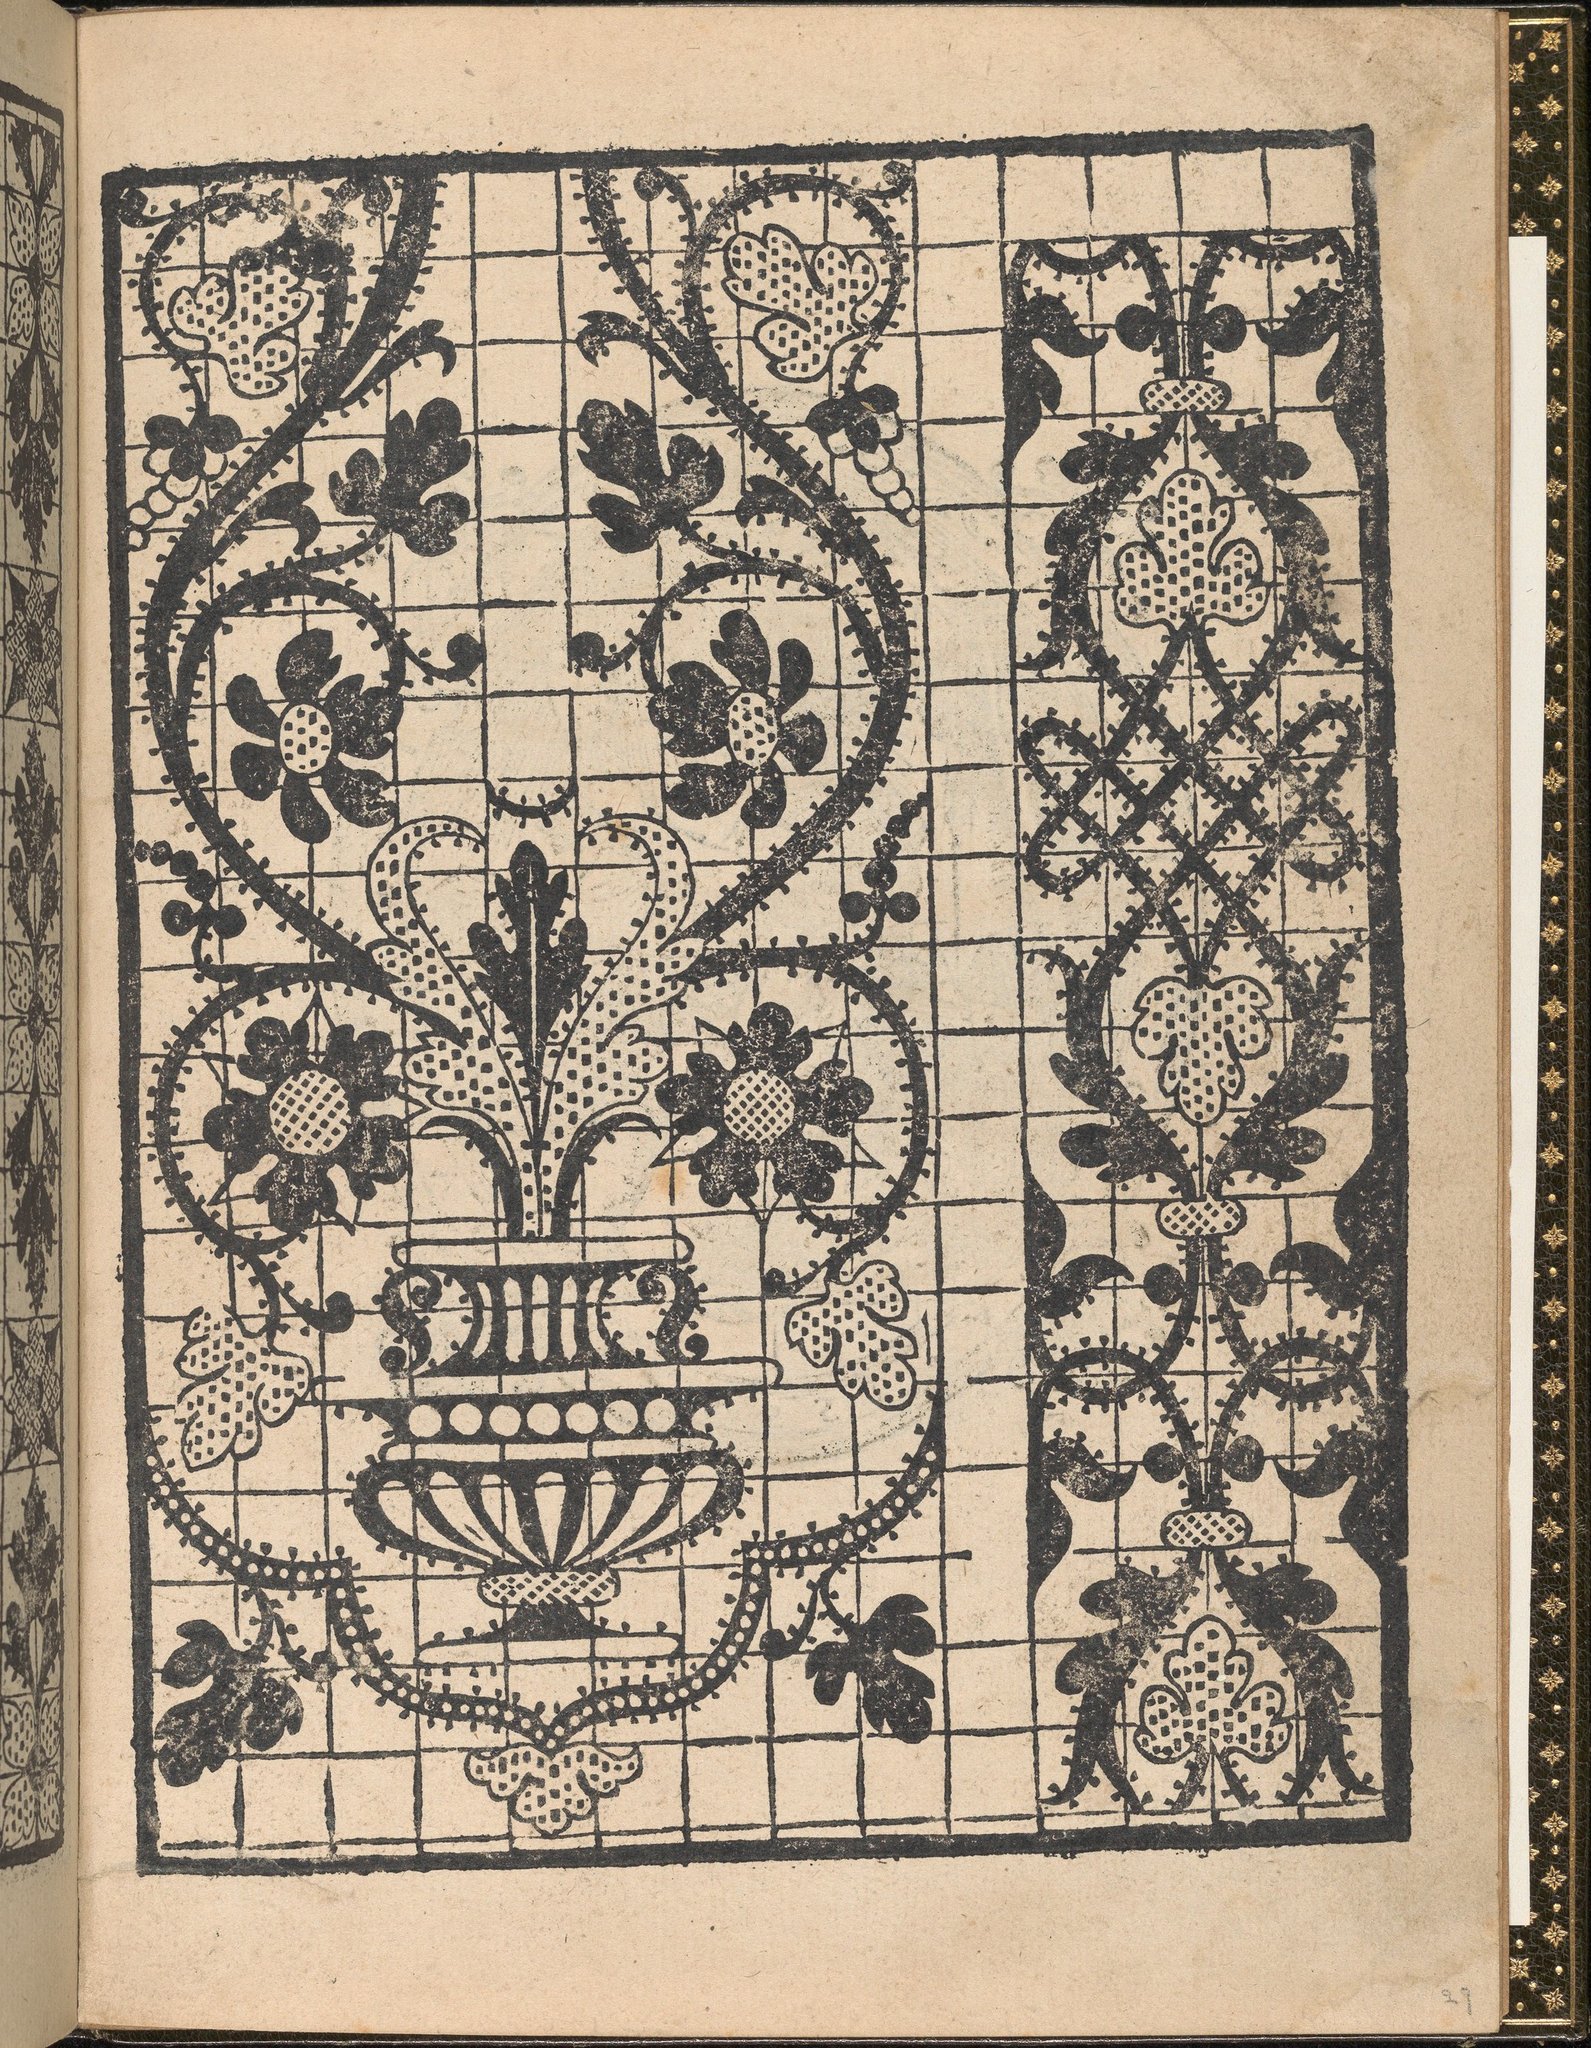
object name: book print ornament architecture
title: La Gloria et l'Honore di Ponti Tagliati, E Ponti in Aere, page 9 (recto)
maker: matteo pagano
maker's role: publisher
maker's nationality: italian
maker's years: 1515-1588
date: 1556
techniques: woodcut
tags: grapes,flowers,vines